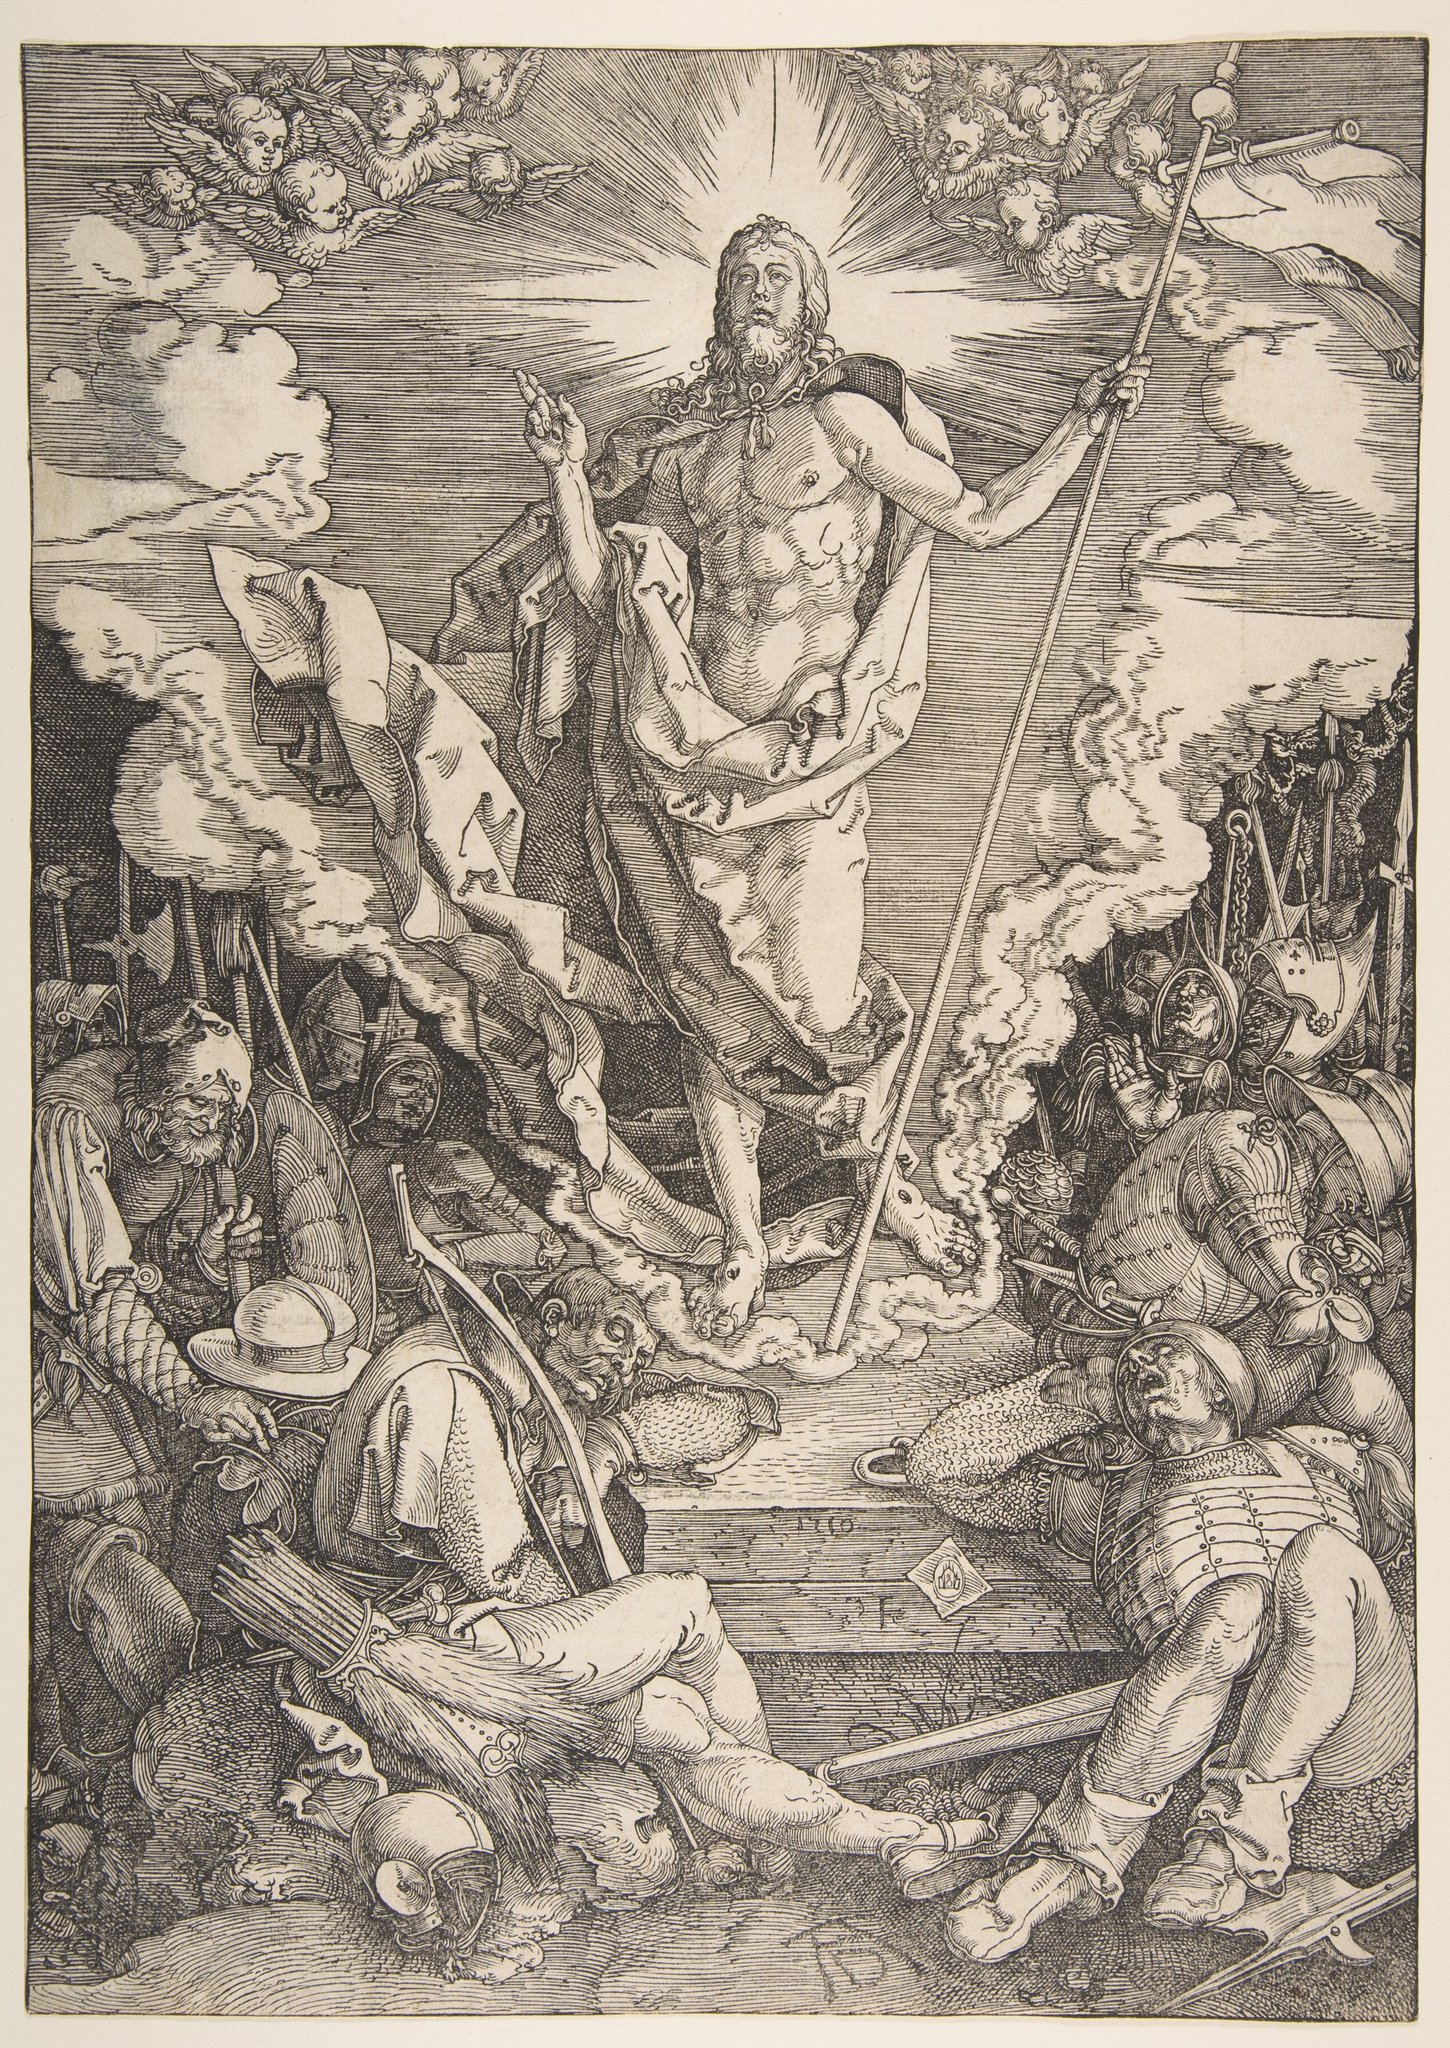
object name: print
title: The Resurrection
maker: albrecht dürer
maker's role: artist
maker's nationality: german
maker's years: 1471-1528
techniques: woodcut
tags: men,christ,resurrection